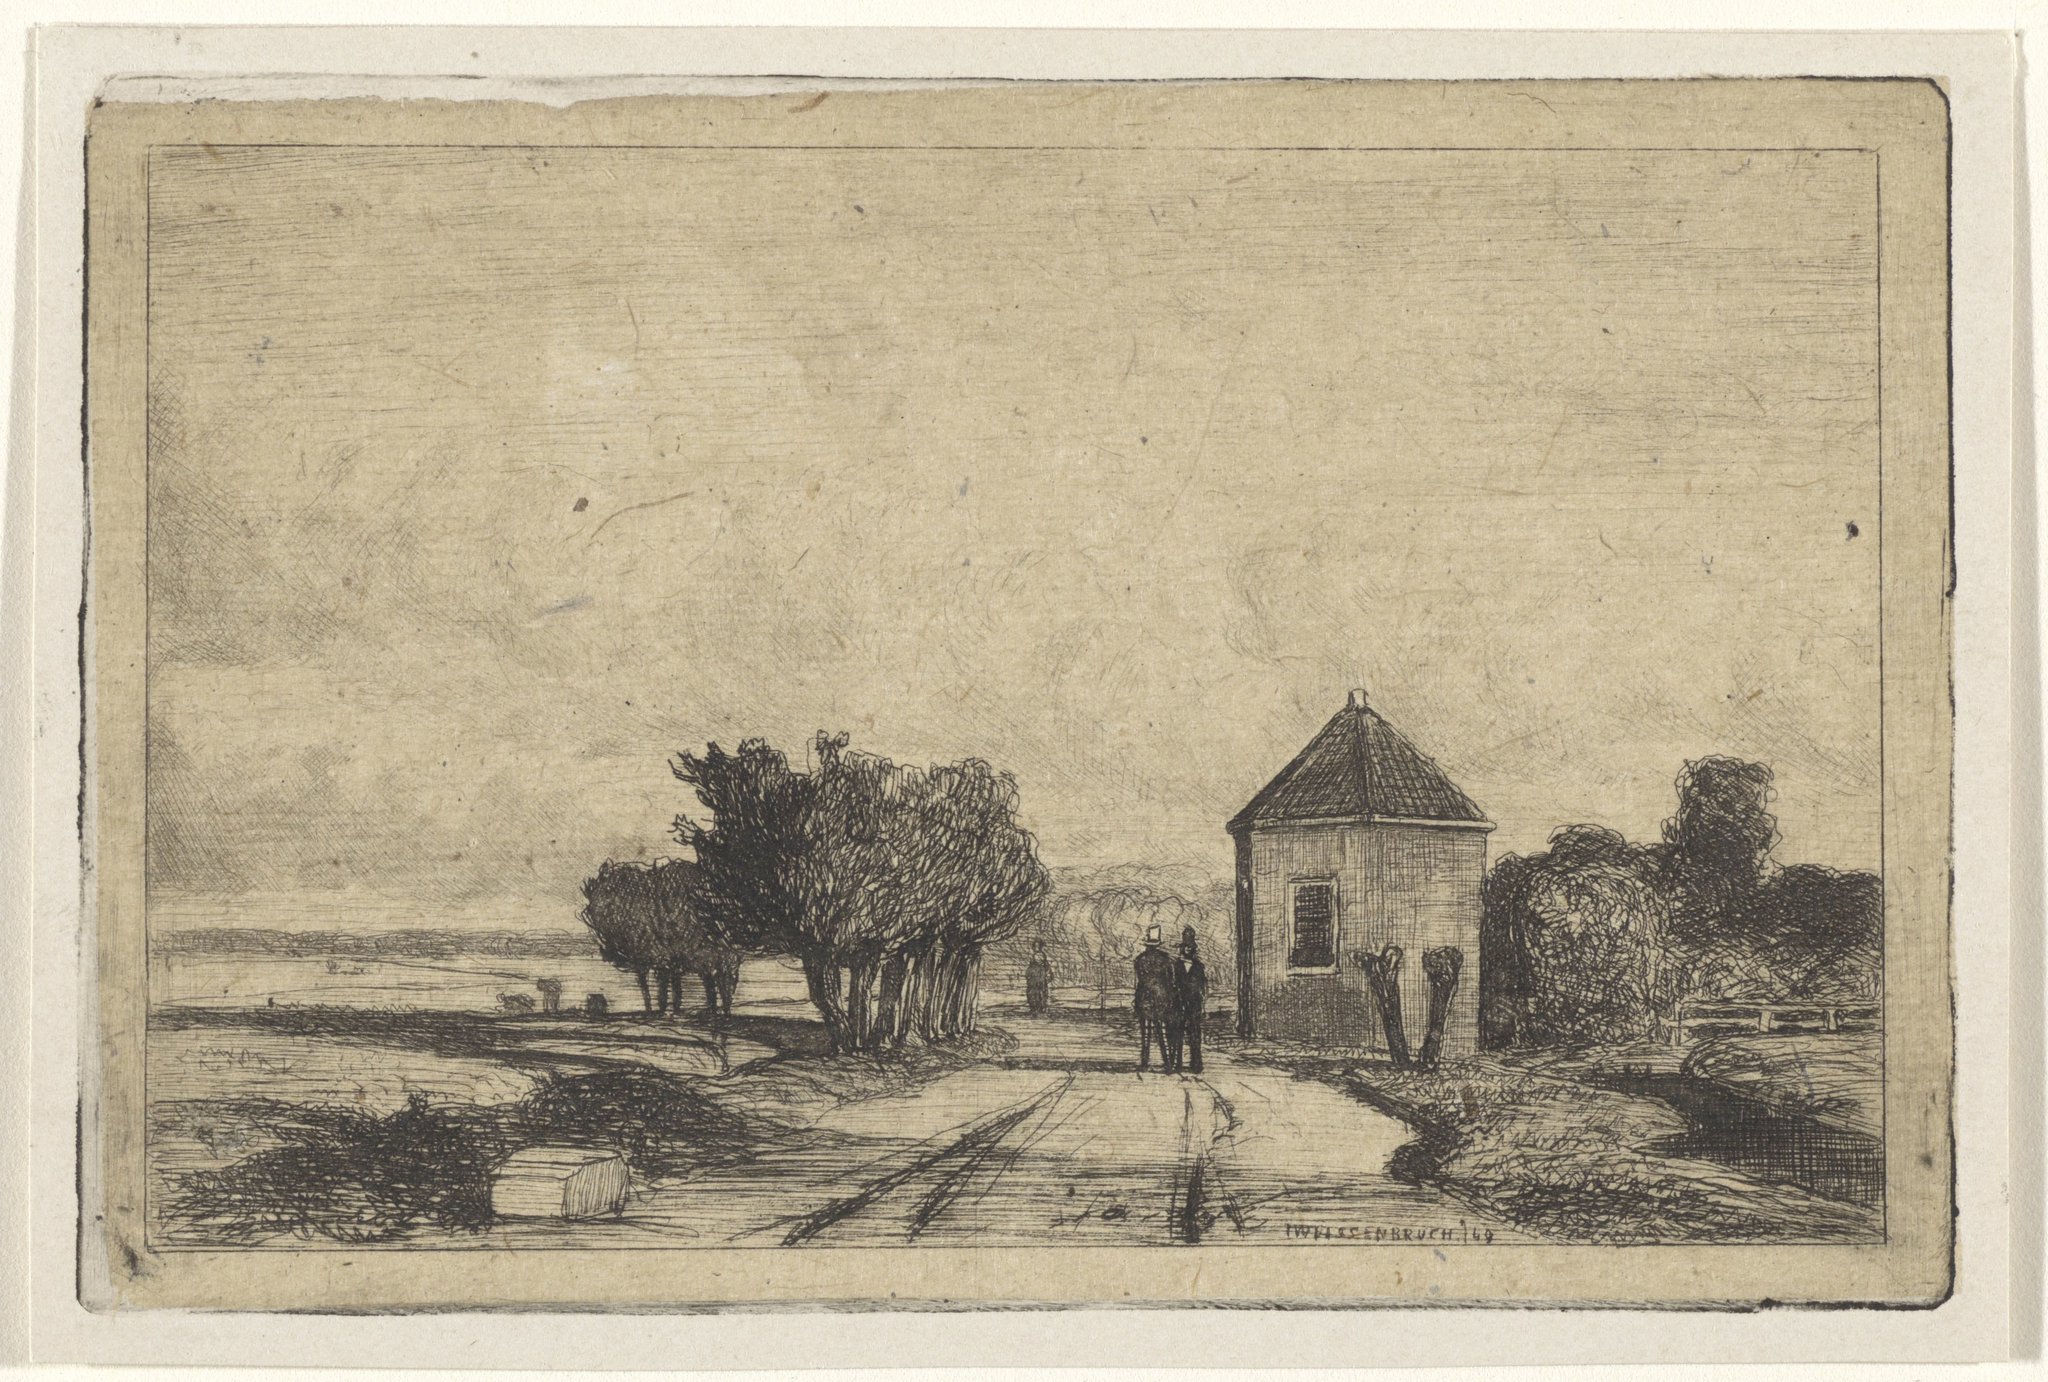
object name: print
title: Gezicht op de Schenkweg met de Koepel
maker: jan weissenbruch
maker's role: painter, print maker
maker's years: 1822-1880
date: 1849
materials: paper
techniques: etching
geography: the hague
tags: trees, landscapes, adult man, road, path, workshop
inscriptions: collector's mark: Lugt 2228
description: Langs de Schenkweg te Den Haag staan enkele bomen. Rechts staat een gebouw dat door de kunstenaar Johannes van der Drift als atelier werd gebruikt. Op de weg staan enkele figuren, onder wie mogelijk leden van de Haagsche Etsclub.